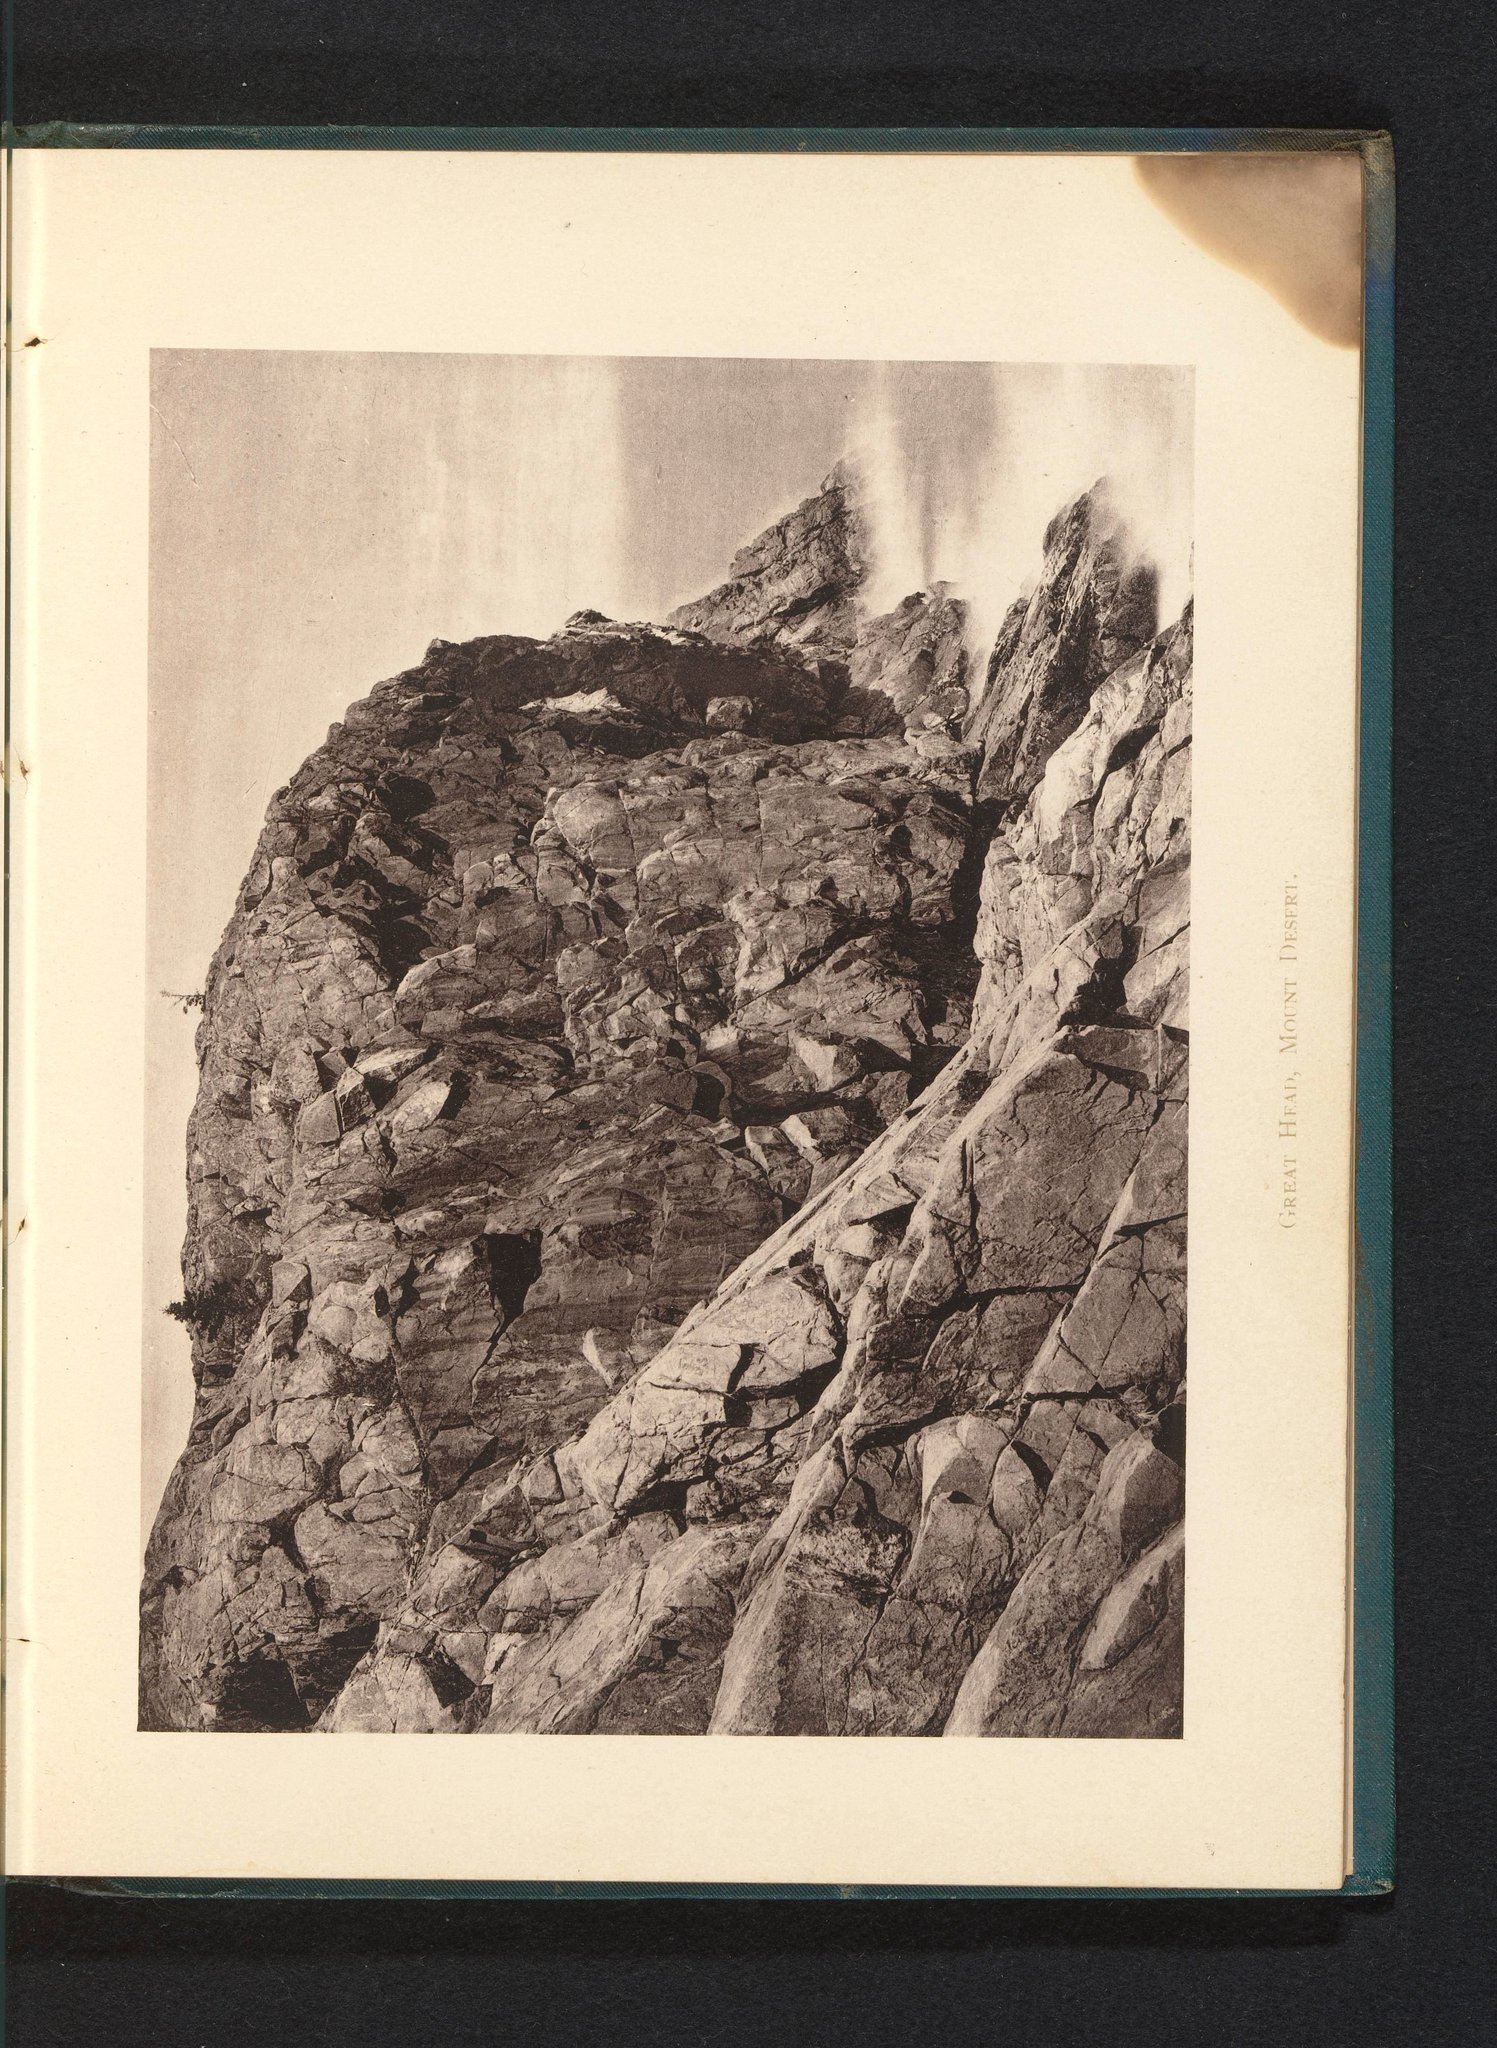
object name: photomechanical print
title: Gezicht op Great Head op Mount Desert Island, Maine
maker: Anonymous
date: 1875-1880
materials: paper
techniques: photograph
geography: great head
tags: cape (coast)